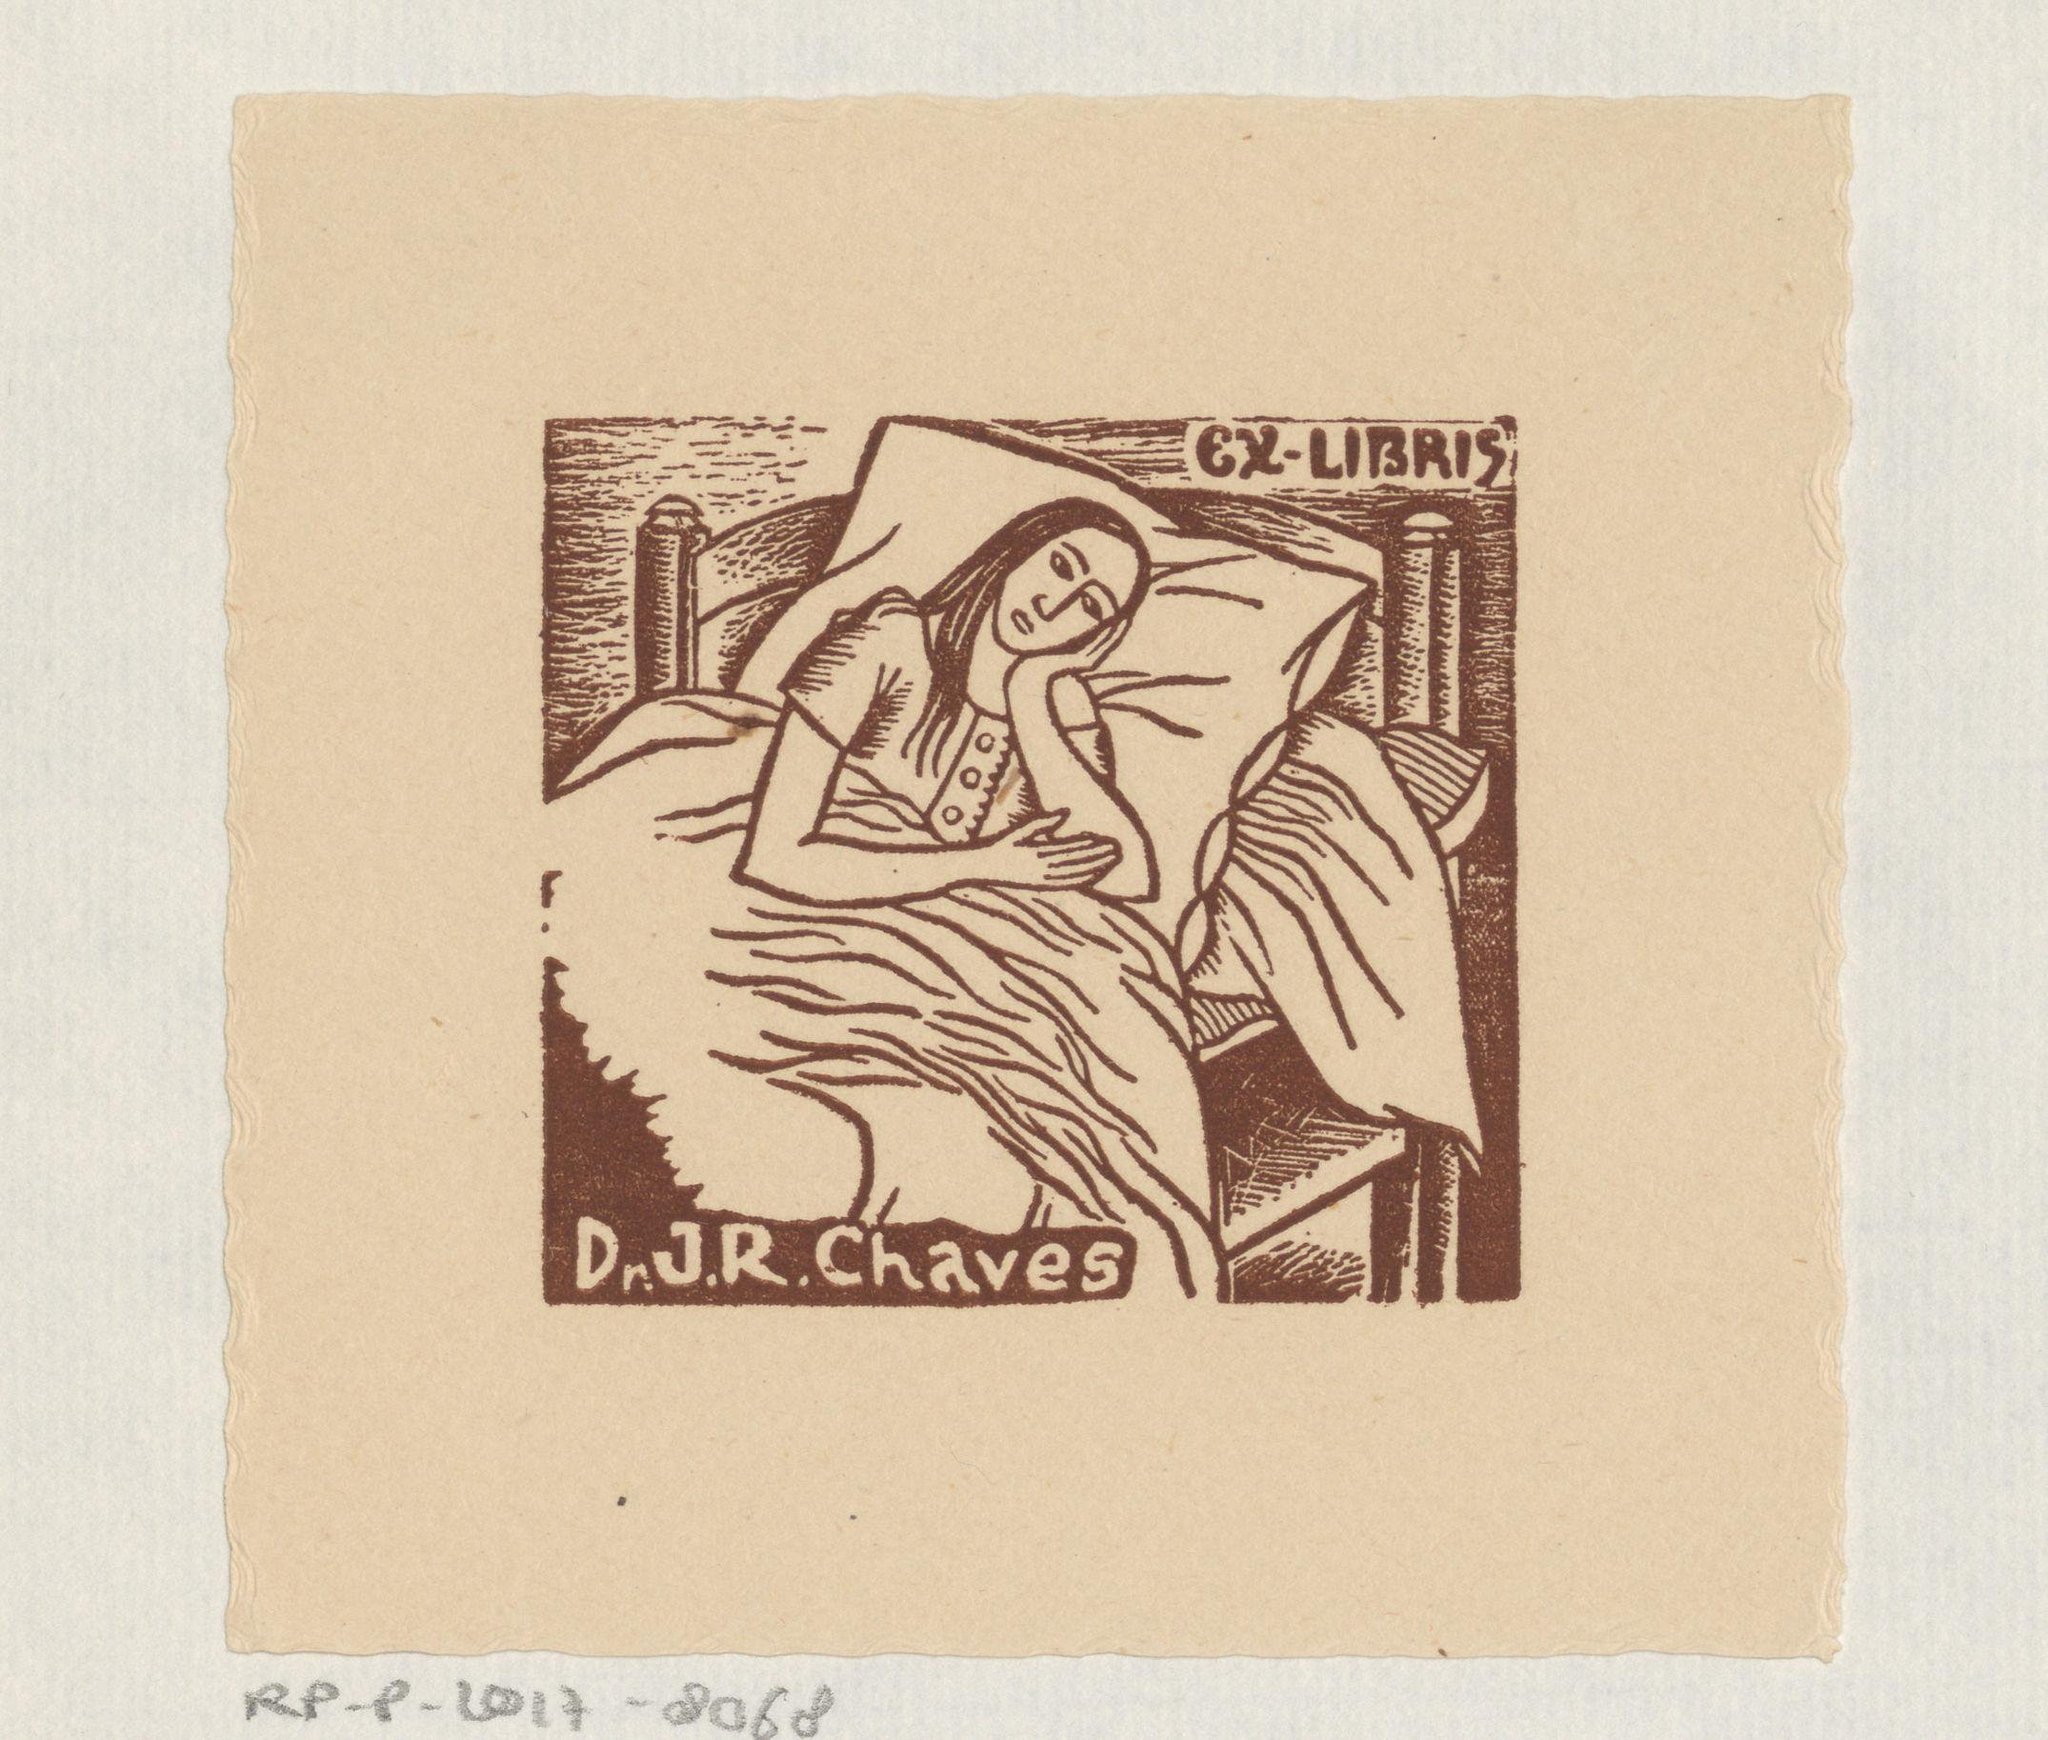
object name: bookplate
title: Ex-libris Dr. J.R.Chaves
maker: Anonymous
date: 1900-1999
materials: paper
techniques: woodcut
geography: spain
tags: josé rodriguez chaves, bed, lying figure - aa - female human figure